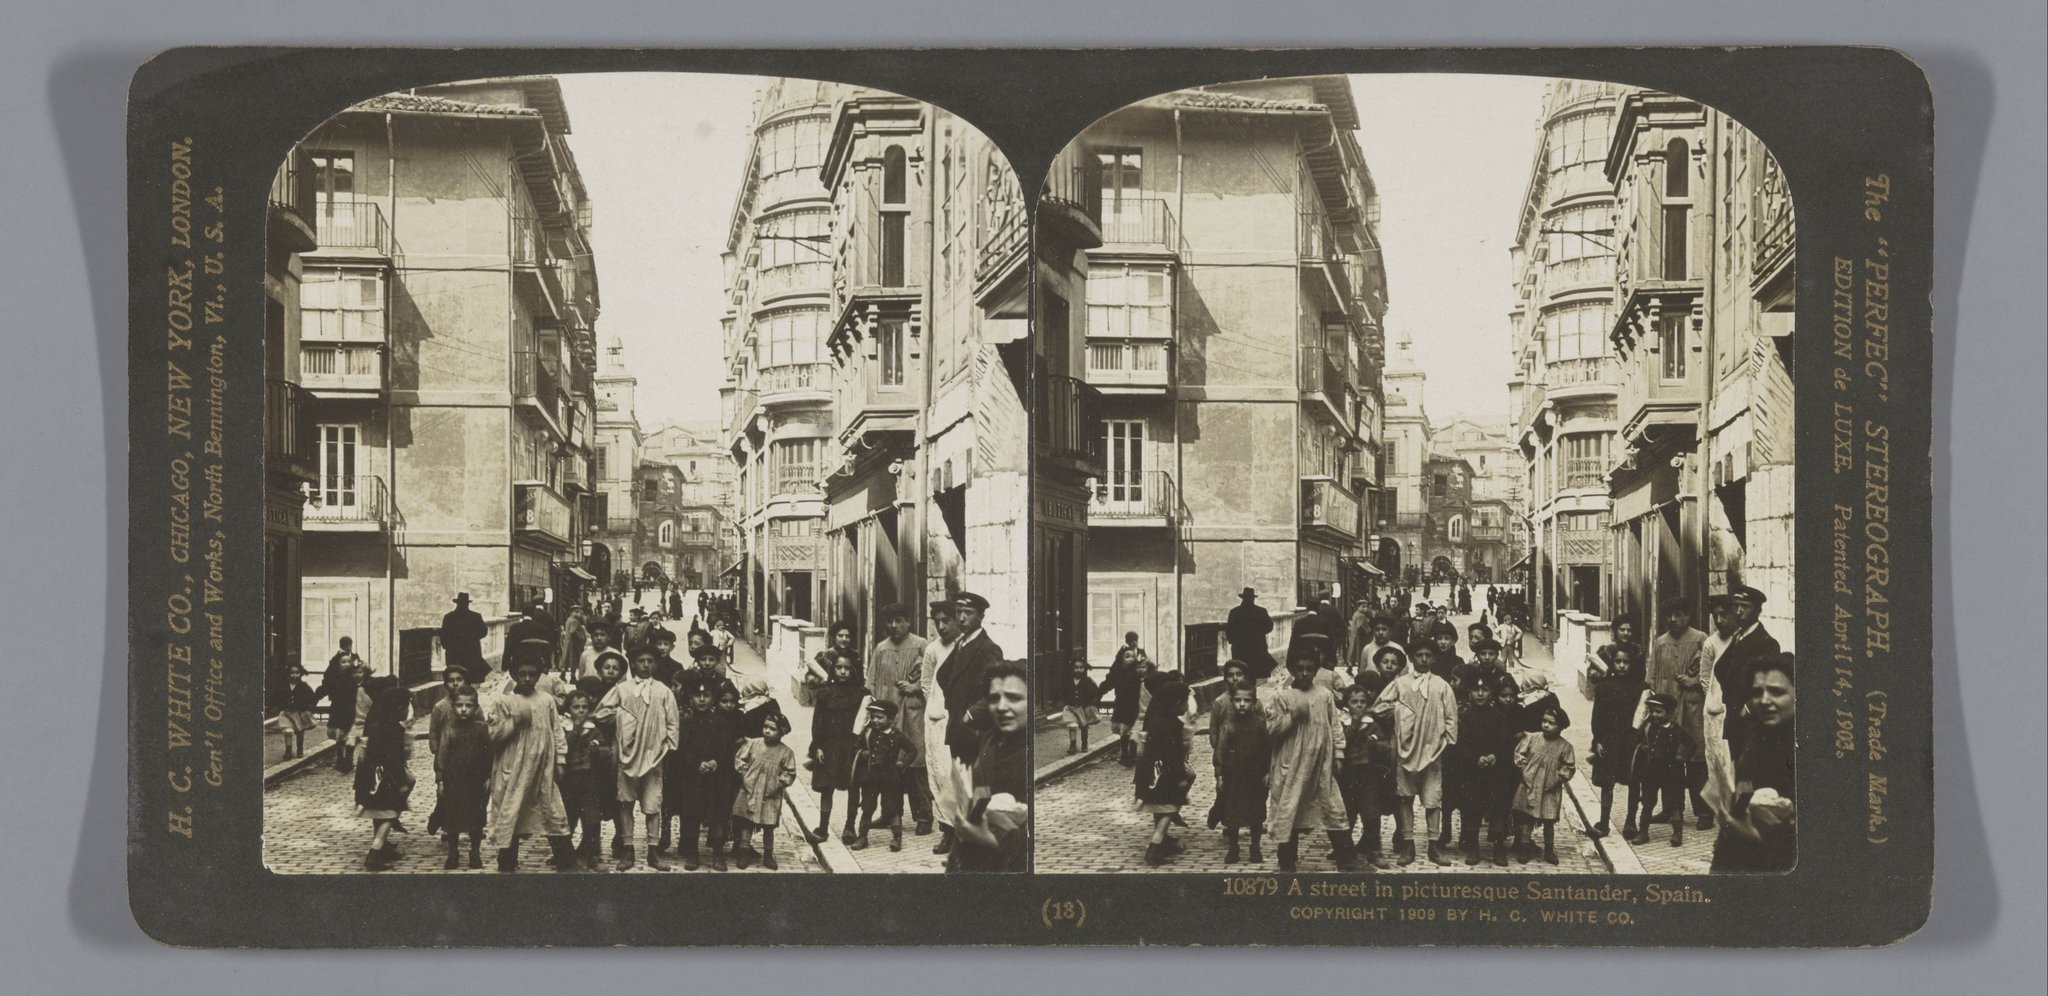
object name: stereograph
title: Gezicht op een straat te Santander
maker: Anonymous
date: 1909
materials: cardboard, photographic support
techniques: gelatin silver print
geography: new york city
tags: crowd, mob, street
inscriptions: inscription: ‘The ''Perfec'' Stereograph. (Trade Mark.) Edition de Luxe. Patented April 14, 1903.’, name: ‘H. C. White Co., Chicago, New York, London. Gen'l Office and Works, North Bennington, Vt., U.S.A.’, inscription: ‘All Perfec-Stereograph subjects may be secured in Lantern Slides and Enlargements.’, number: ‘10879’